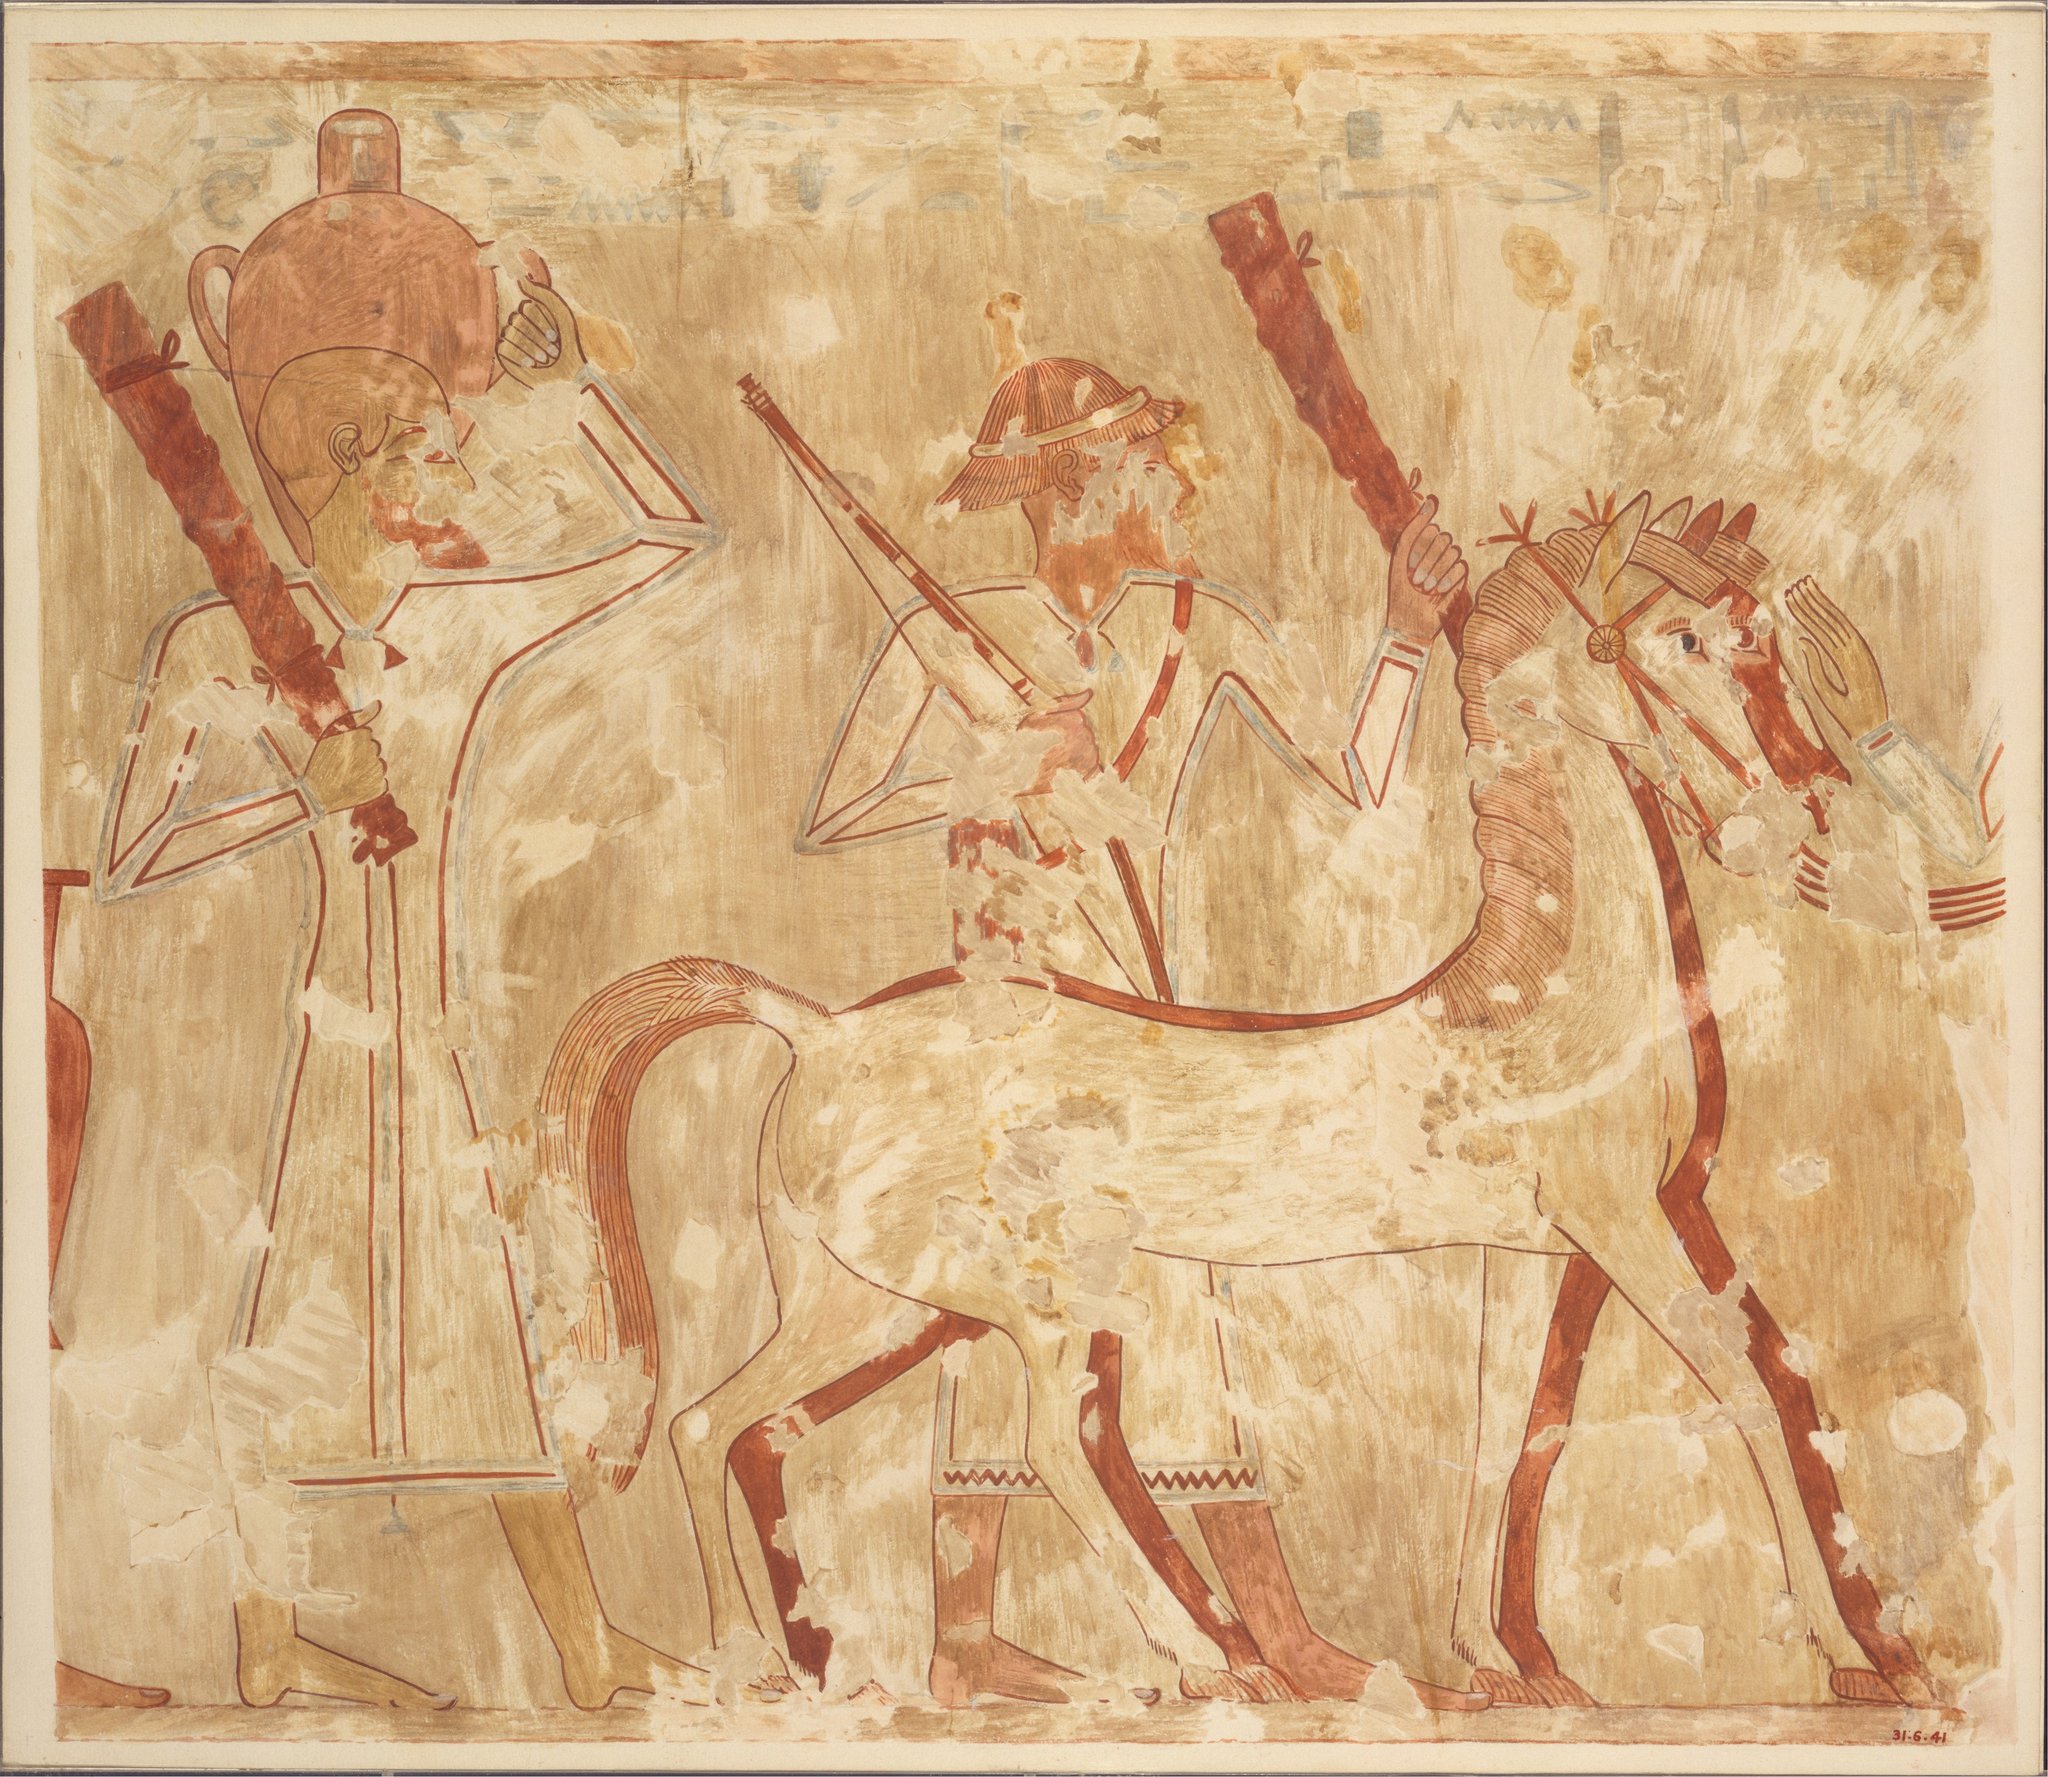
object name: facsimile, rekhmire tt 100, syrian, horse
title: Syrians Bringing Horses, Tomb of Rekhmire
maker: nina de garis davies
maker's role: artist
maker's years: 1881-1965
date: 1504-1425 BCE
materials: paper, paint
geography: egypt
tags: men,horses,rekhmire-exhibition